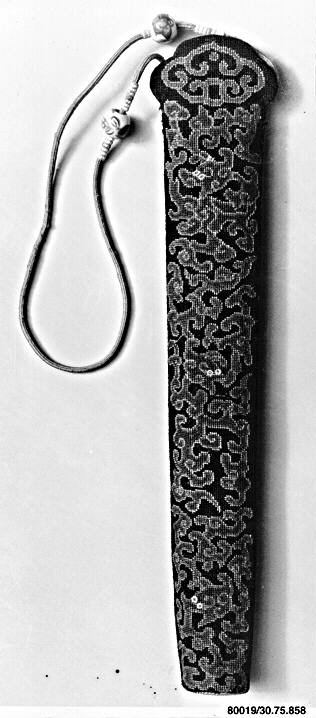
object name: fan holder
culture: chinese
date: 1701-1900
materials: silk